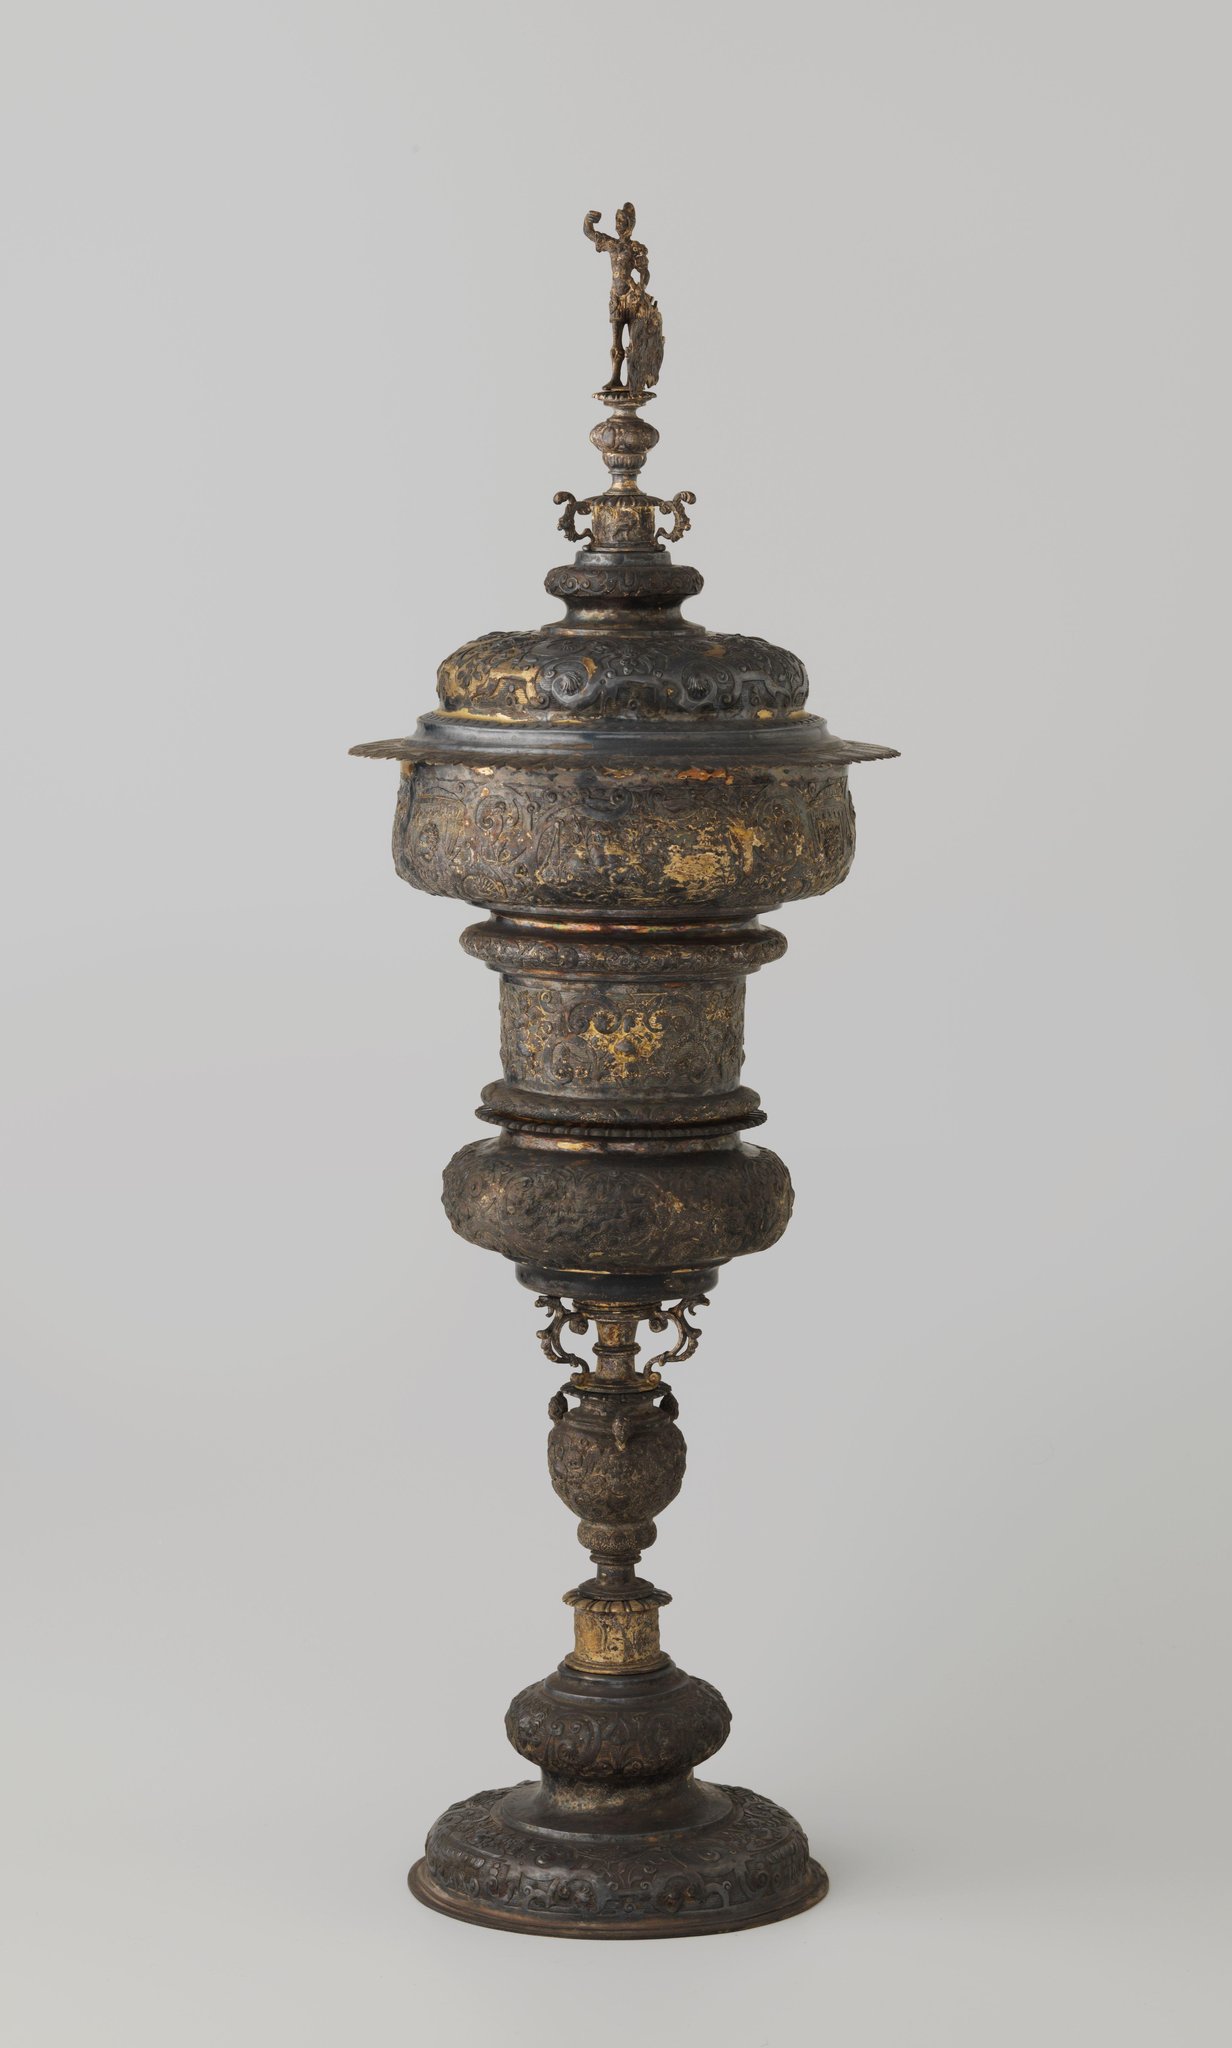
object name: cup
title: Galvanoplastische reproductie van de "Interimspokal" uit het Lüneburger Ratssilber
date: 1552-1553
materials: copper, silver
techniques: gilding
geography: berlin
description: Galvanoplastische reproductie van de "Interimspokal". Gedreven en verguld.